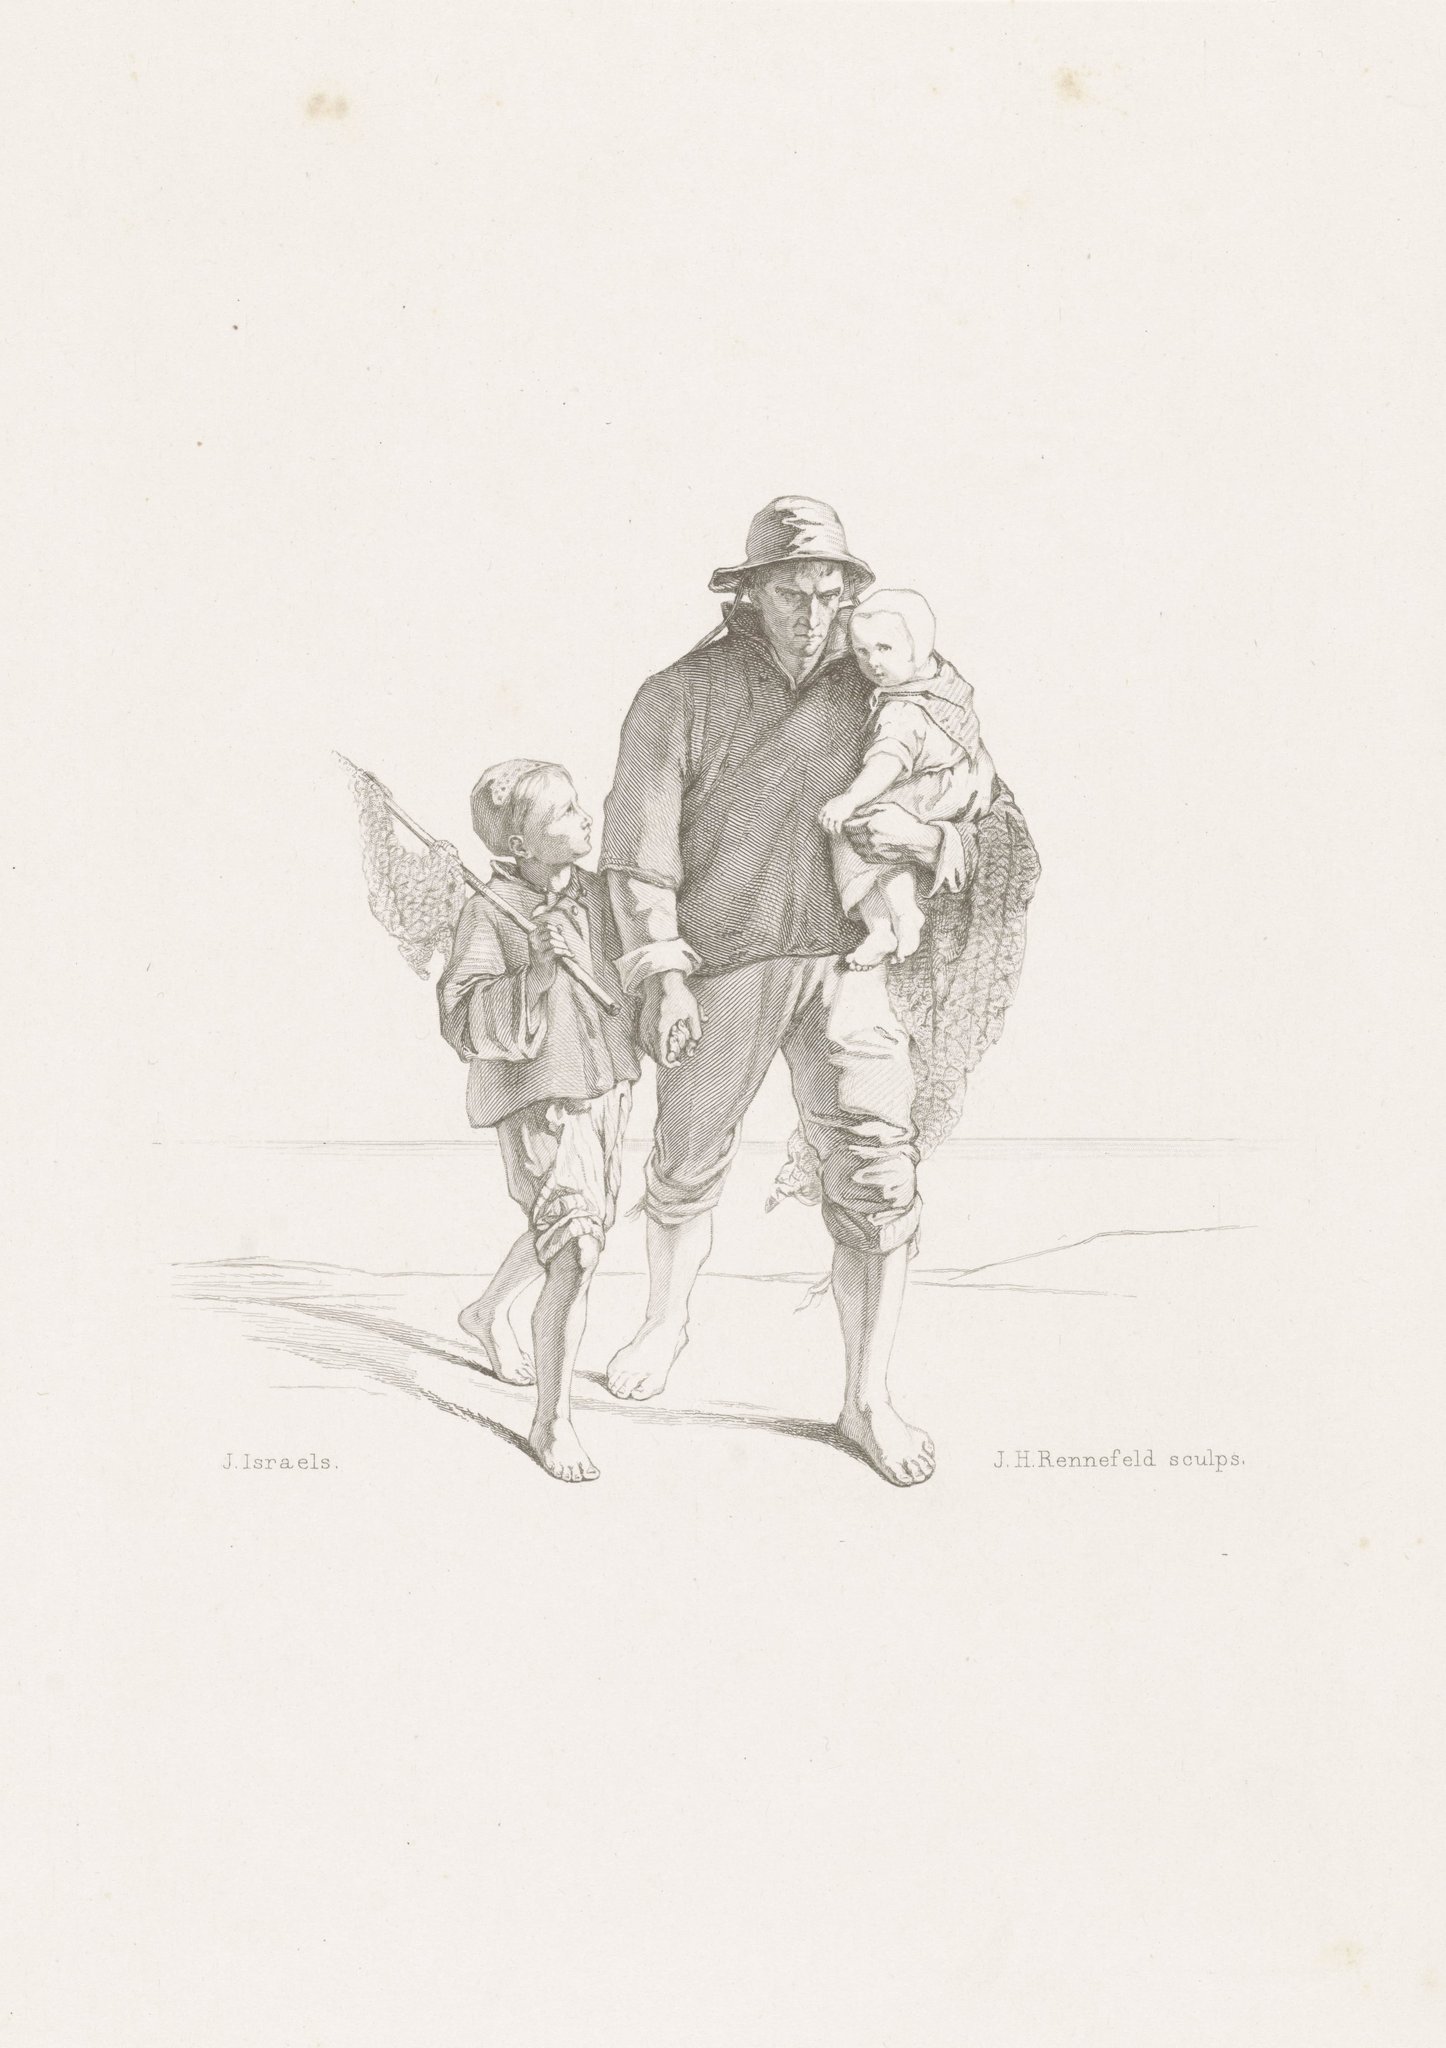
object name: print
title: Passing Mother’s Grave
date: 1859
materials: paper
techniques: roulette, engraving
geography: amsterdam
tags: fisherman, father and child(ren), man and child(ren) (family group)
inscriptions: collector's mark: Lugt 2228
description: Een visser loopt met zijn kinderen langs het graf van de overleden moeder. De prent maakt deel uit van de serie prenten 'De kinderen der zee'.